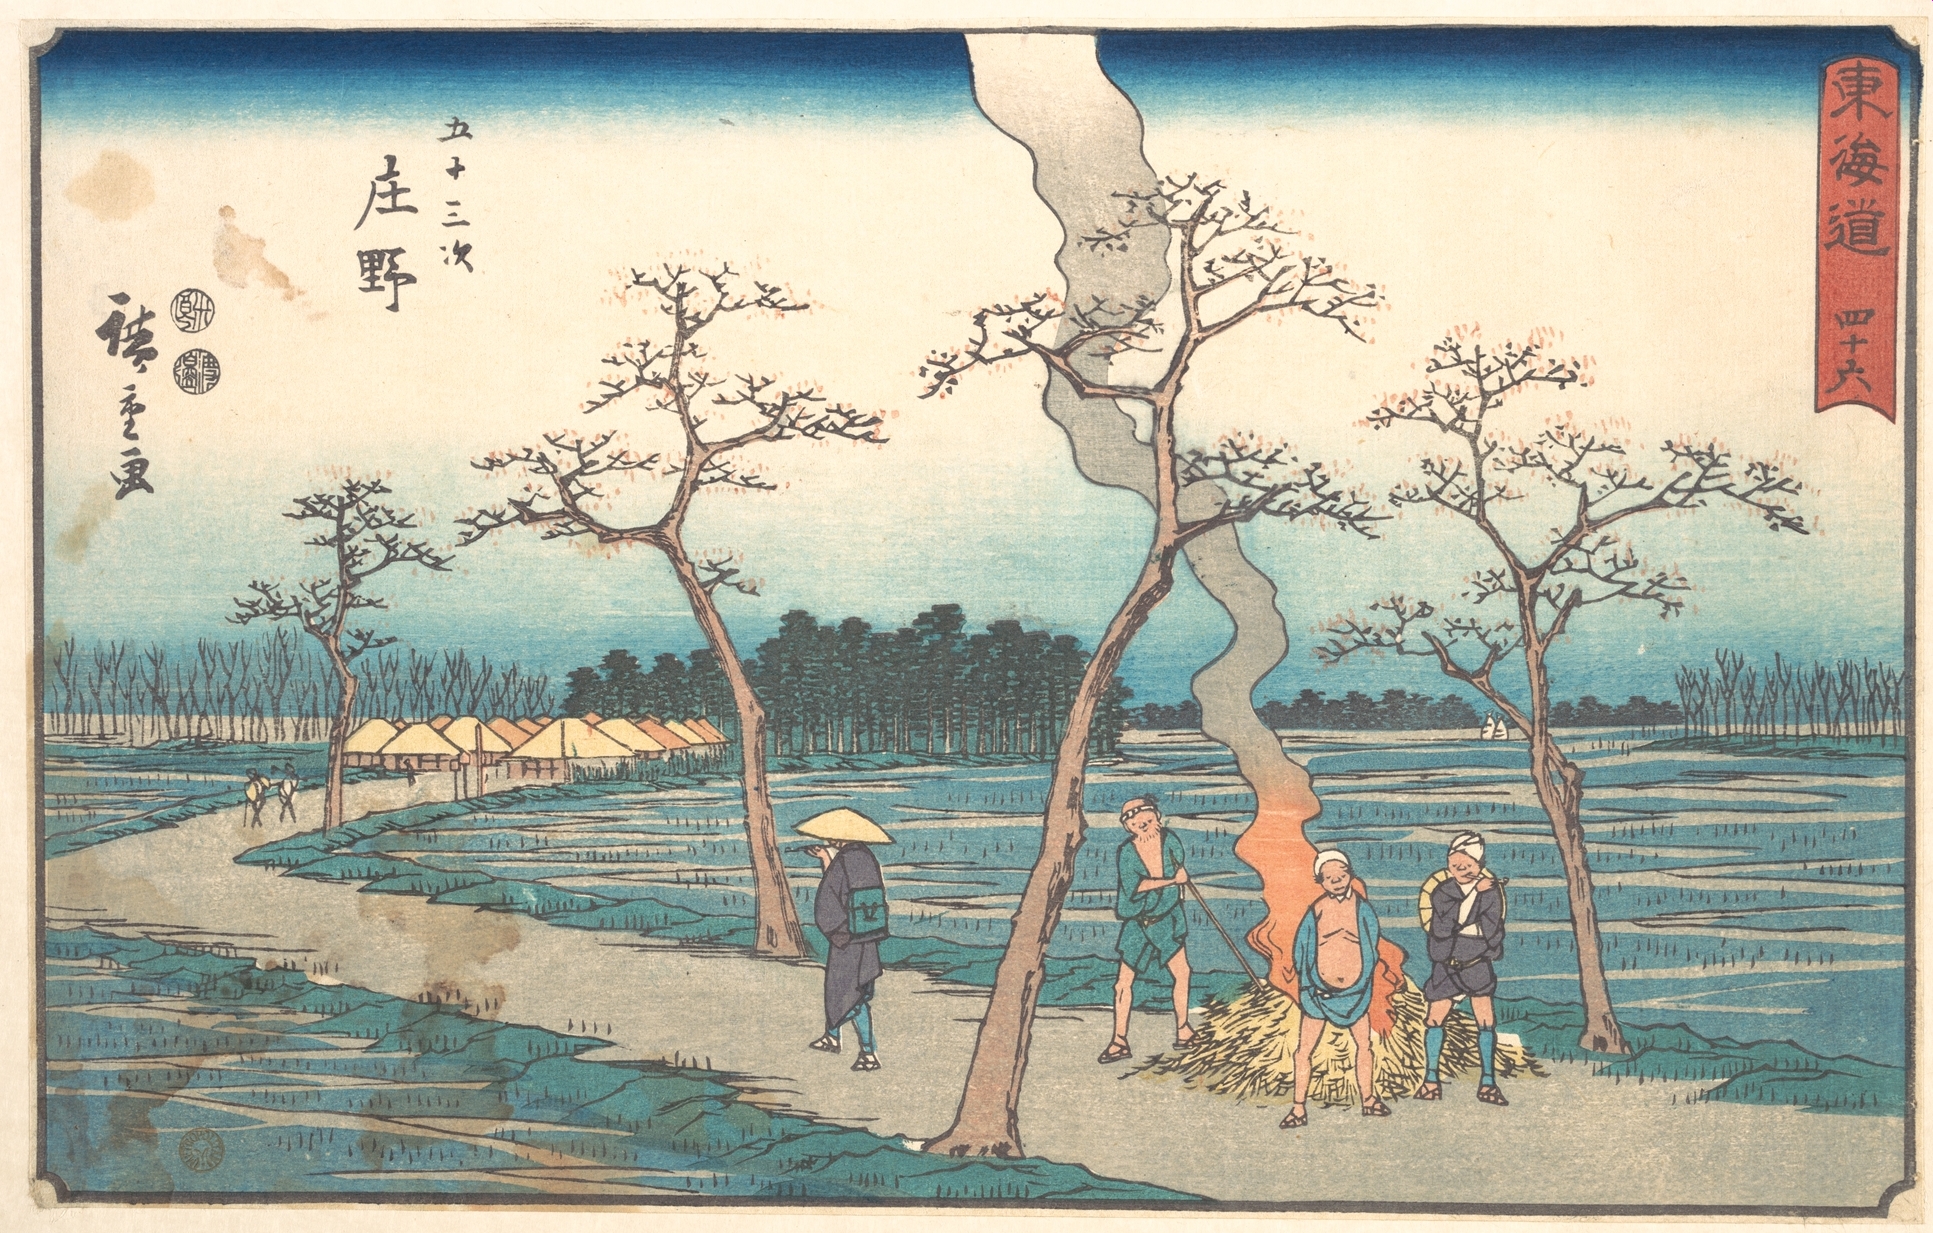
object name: print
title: Shono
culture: japanese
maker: utagawa hiroshige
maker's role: artist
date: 1840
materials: ink, paper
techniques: woodblock print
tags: men,fire,landscapes,trees